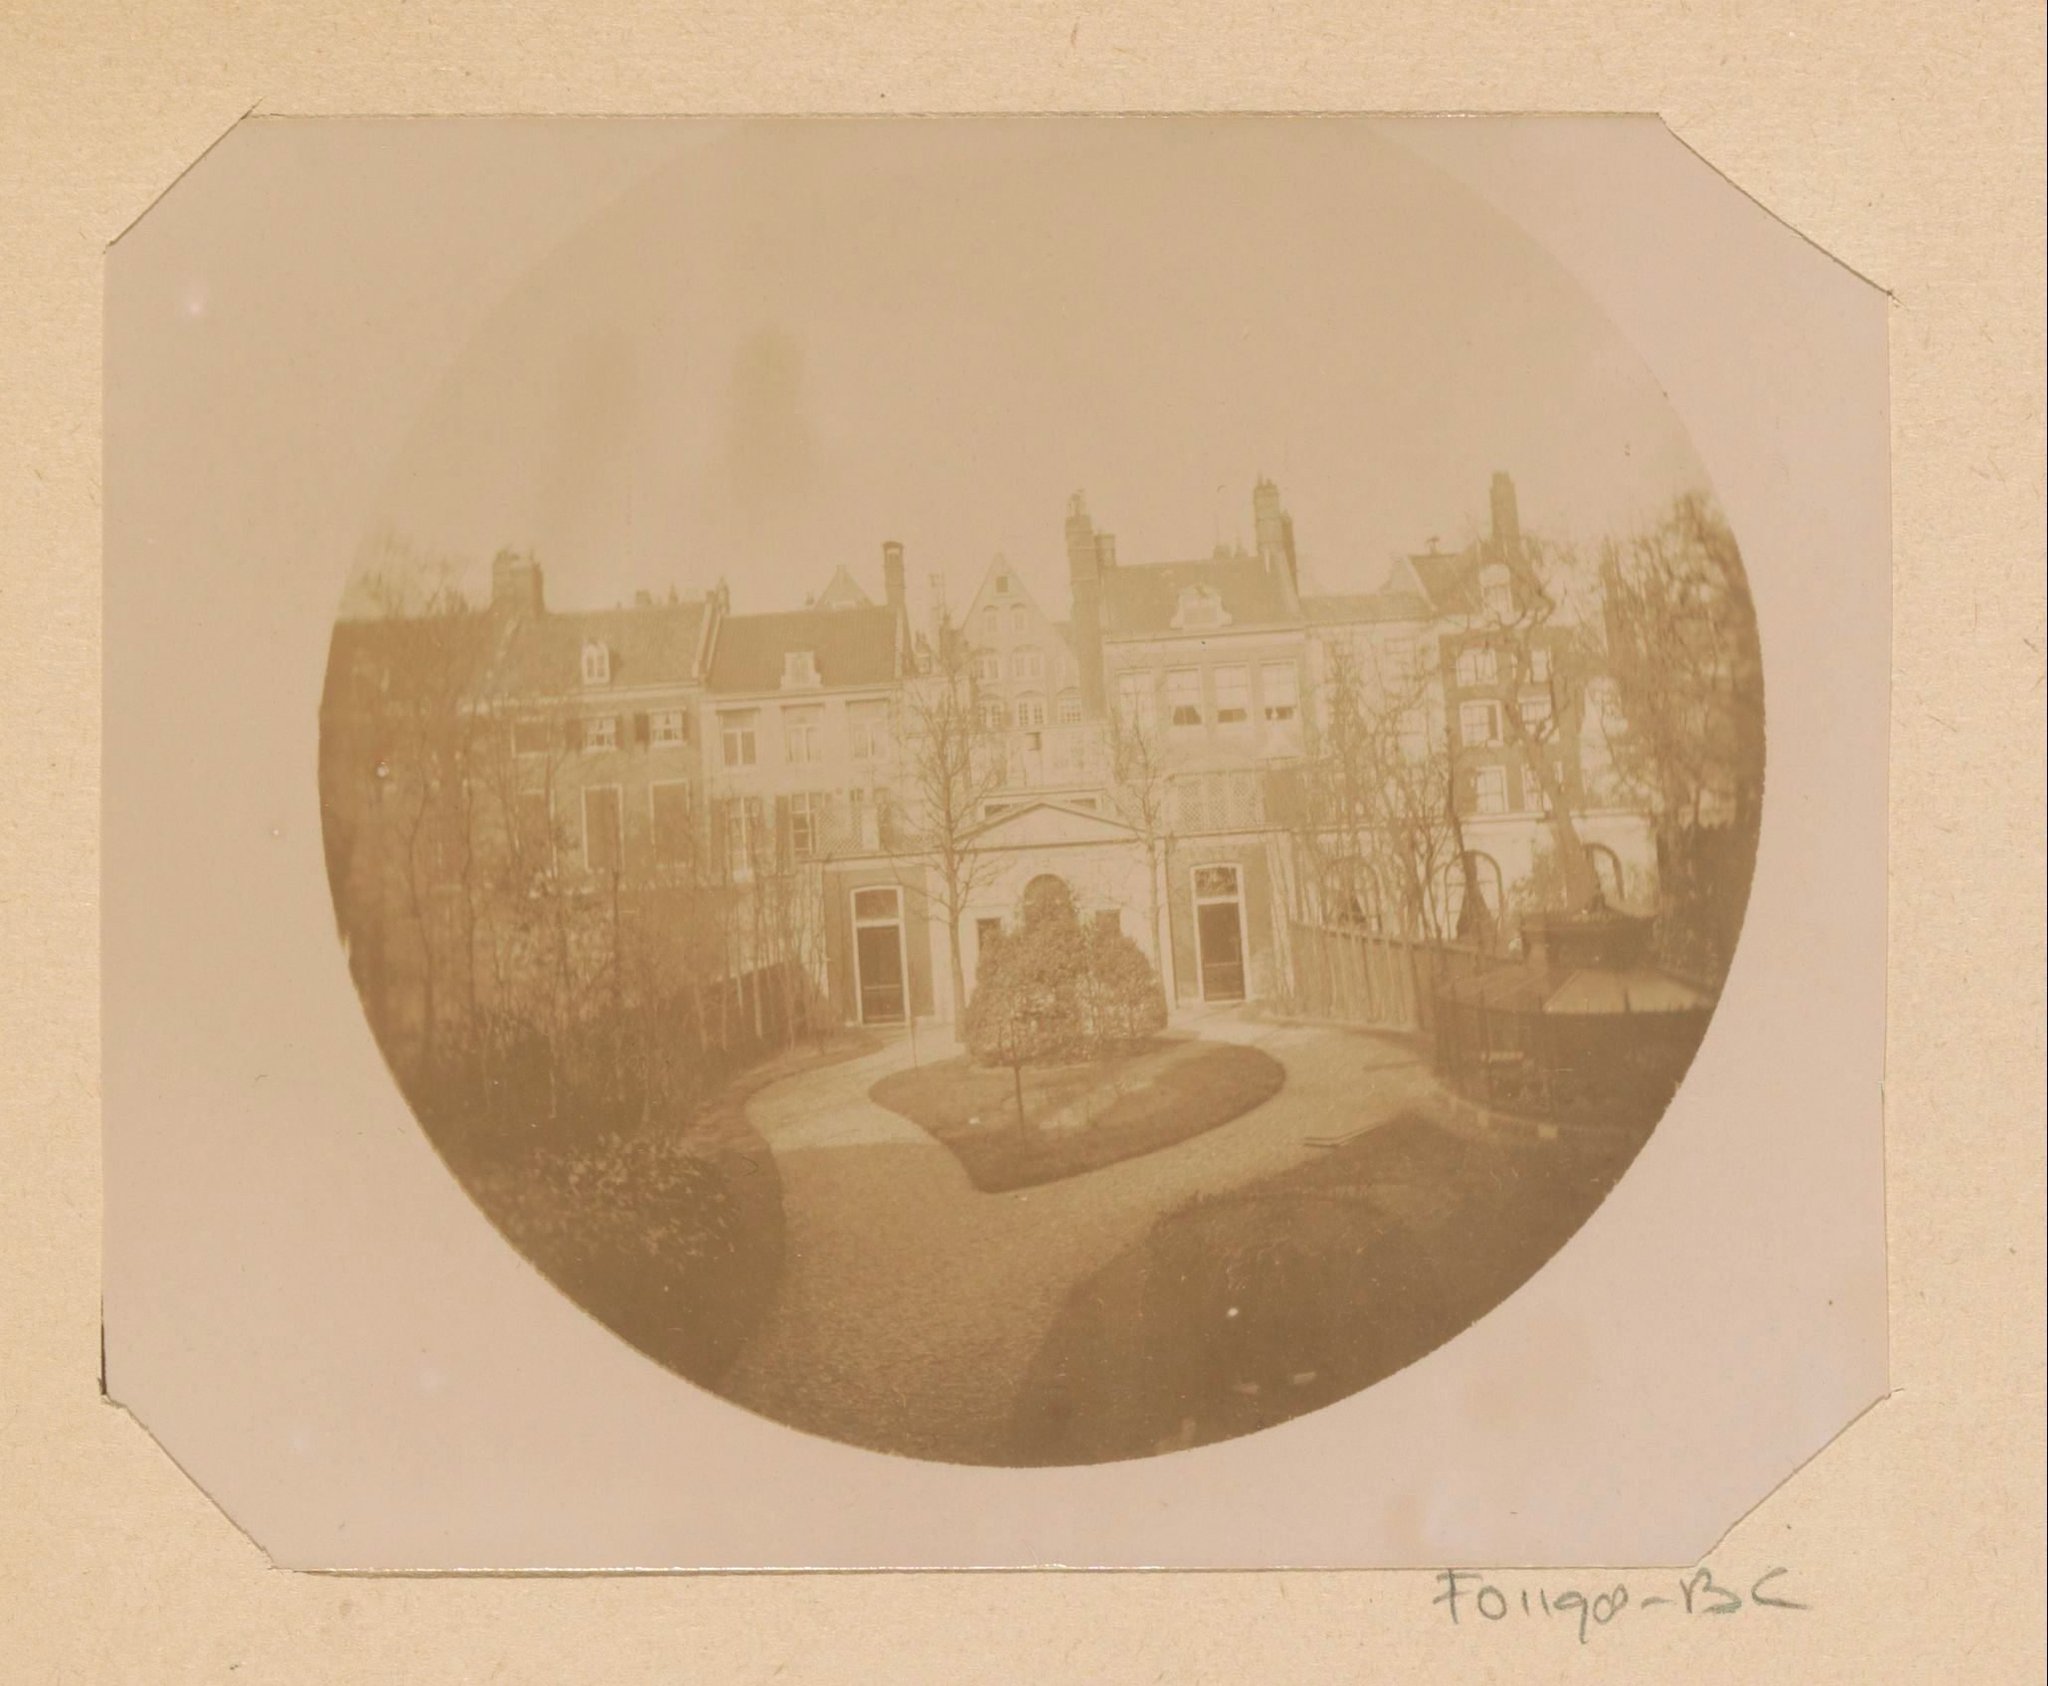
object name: photograph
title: Gezicht op de achtertuin van Herengracht 258, Amsterdam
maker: johanna margaretha piek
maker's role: fotograaf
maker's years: 1870-1947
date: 1889-1893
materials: paper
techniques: gelatin silver print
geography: amsterdam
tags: backyard, amsterdam